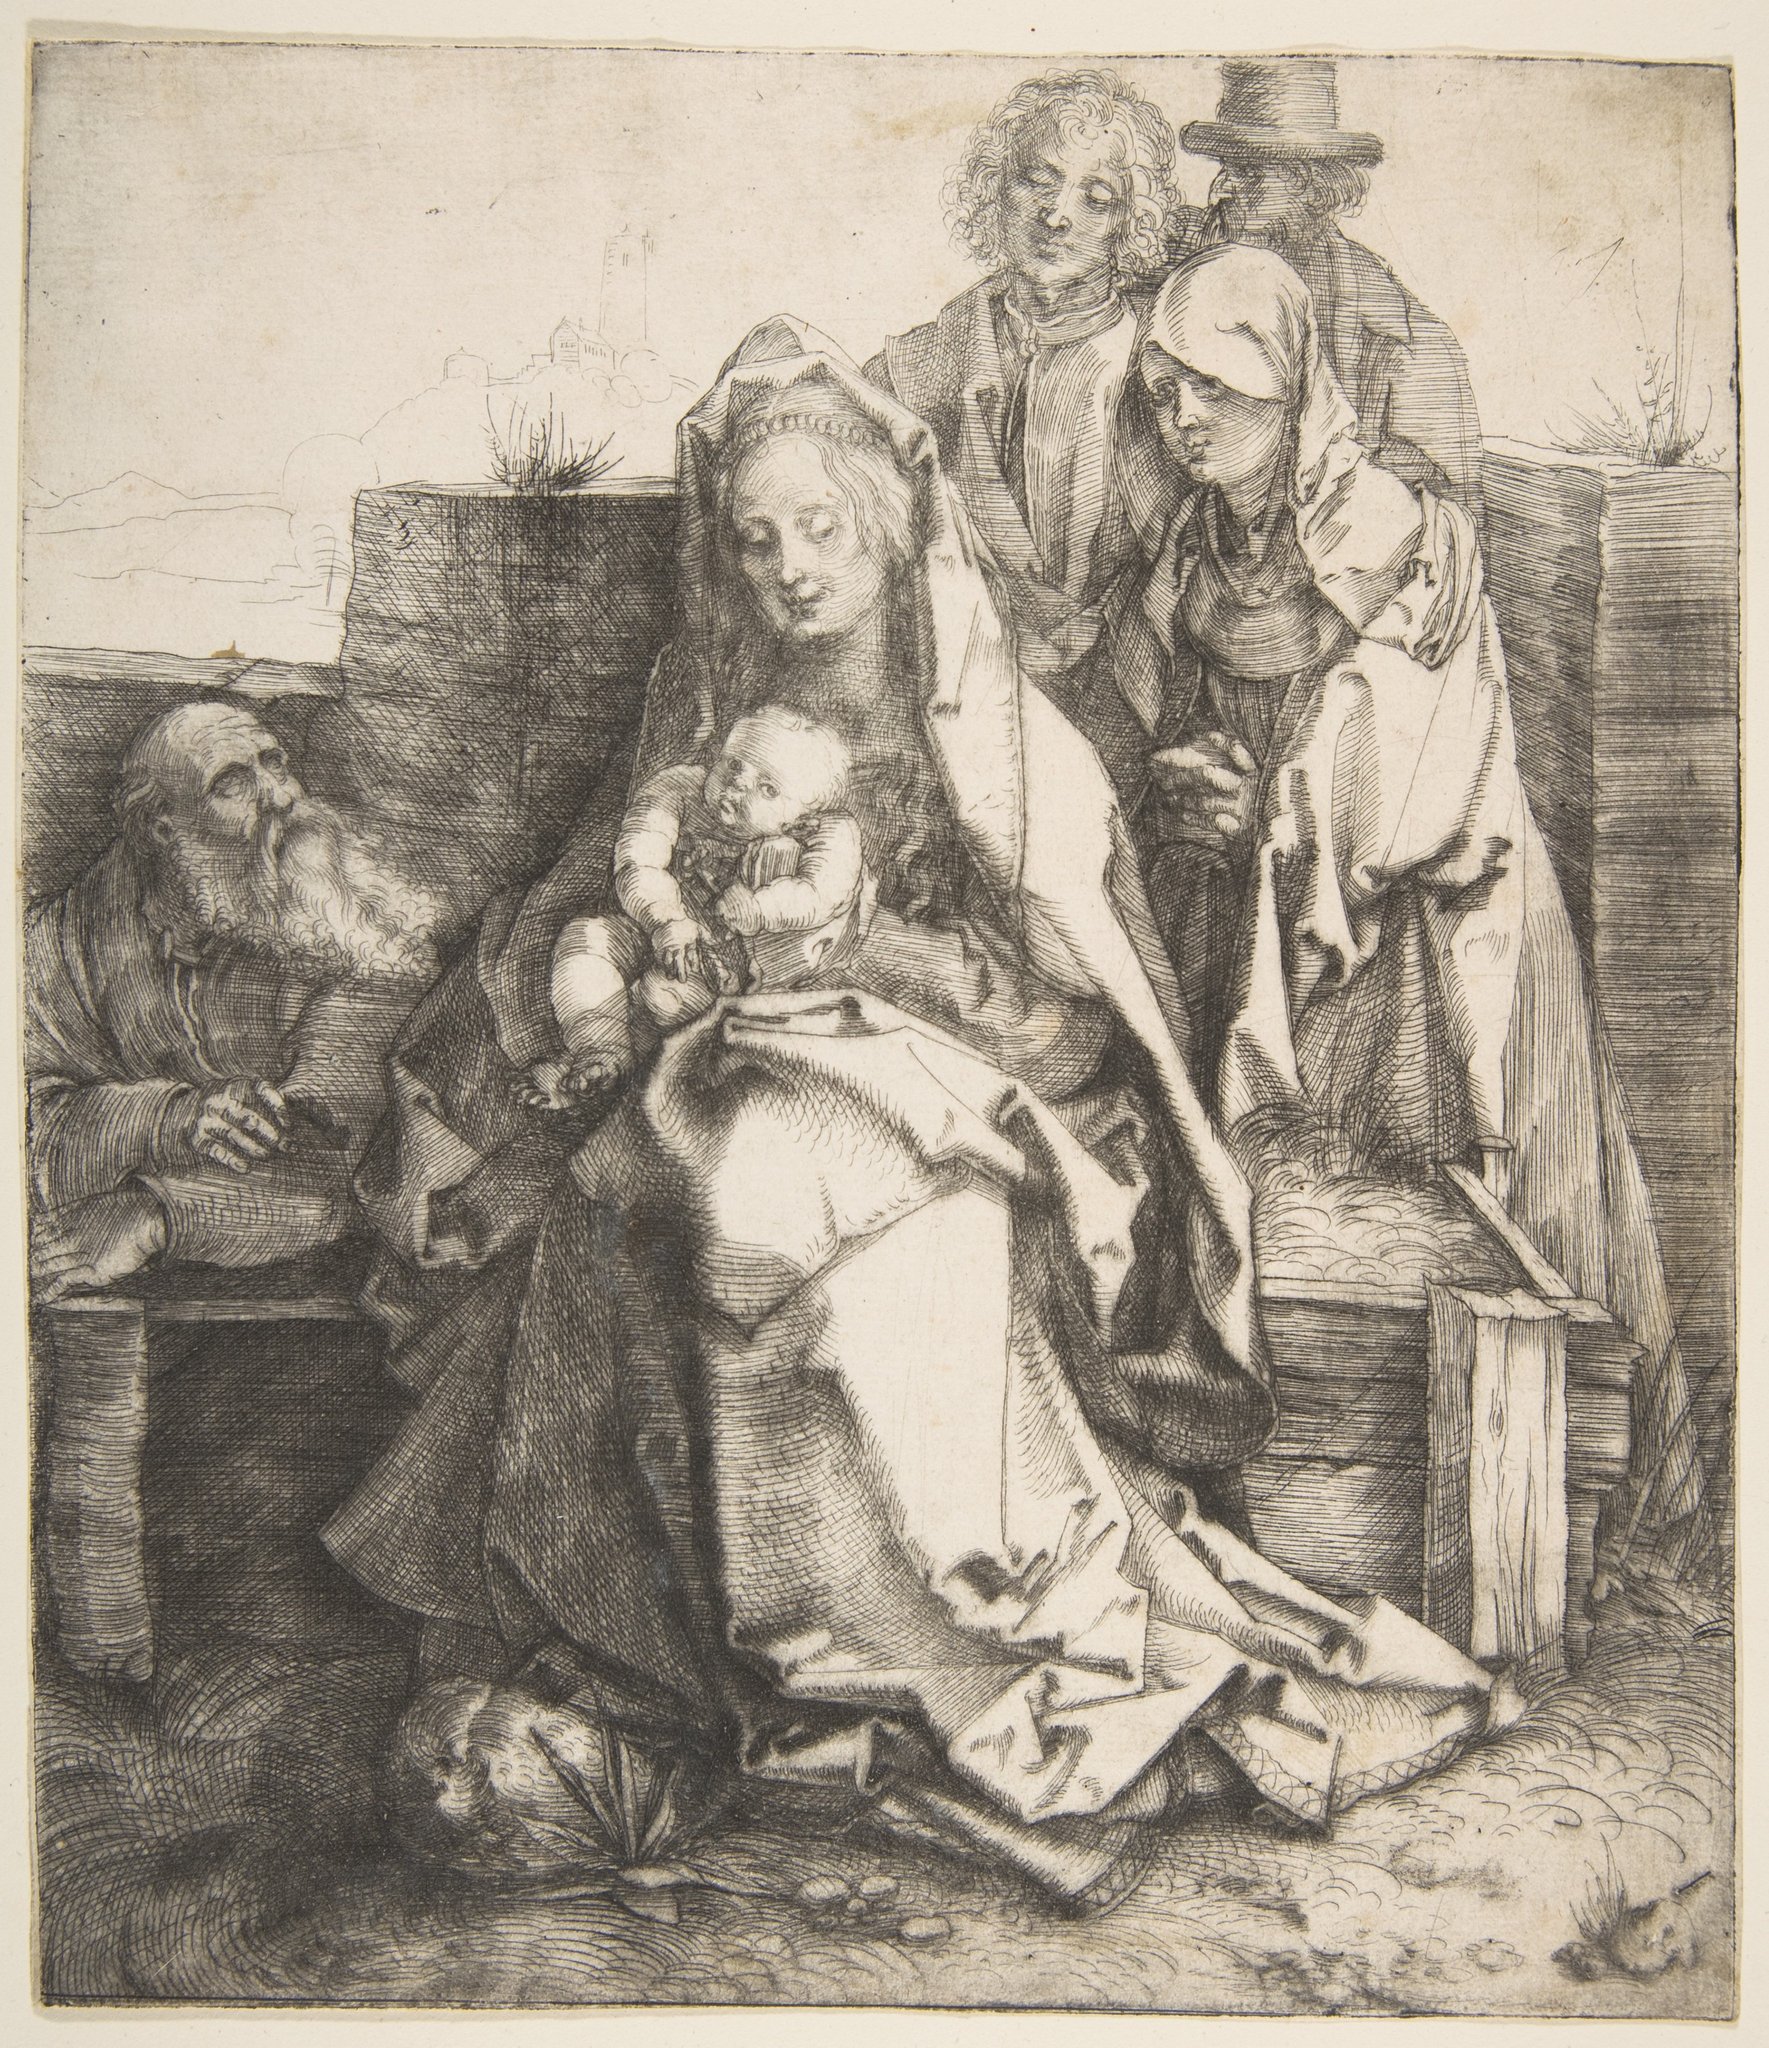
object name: print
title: The Holy Family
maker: albrecht dürer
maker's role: artist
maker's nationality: german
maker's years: 1471-1528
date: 1512-1513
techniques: drypoint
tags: men,women,holy family,virgin mary,jesus,joseph